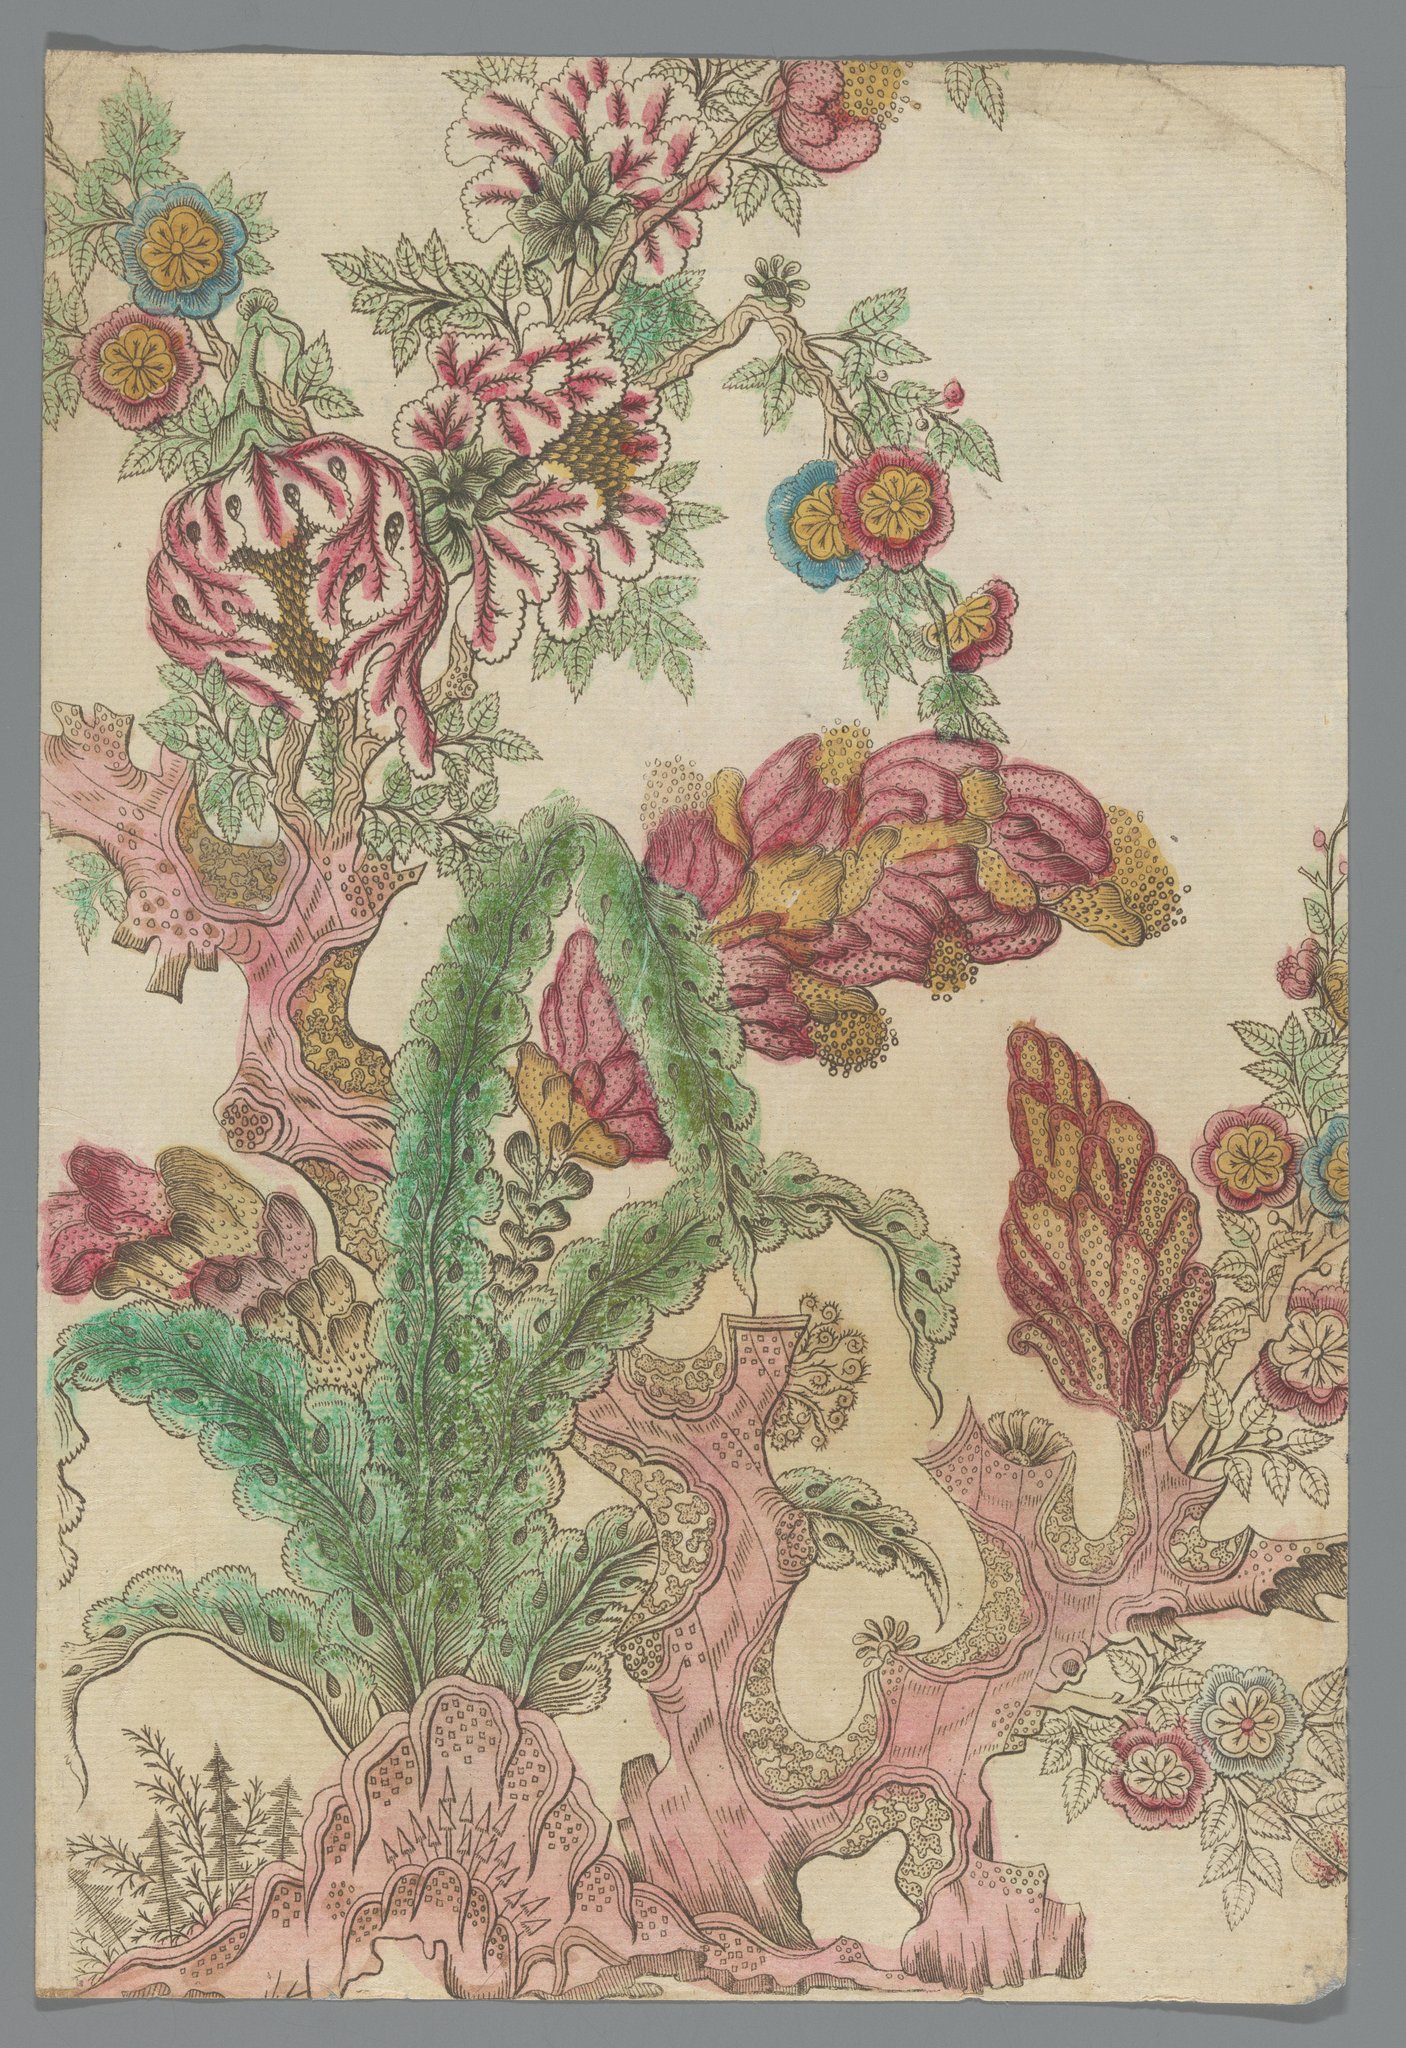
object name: print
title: Grillige takken met bloemen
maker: Anonymous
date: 1750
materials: paper, watercolor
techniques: etching, hand coloring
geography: paris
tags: ornament derived from plant forms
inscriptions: collector's mark: Lugt 2228, collector's mark: Lugt 2760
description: Grillige takken met bloemen en knoppen. Een van 39 bladen met knipplaatjes en decoratieve randen.